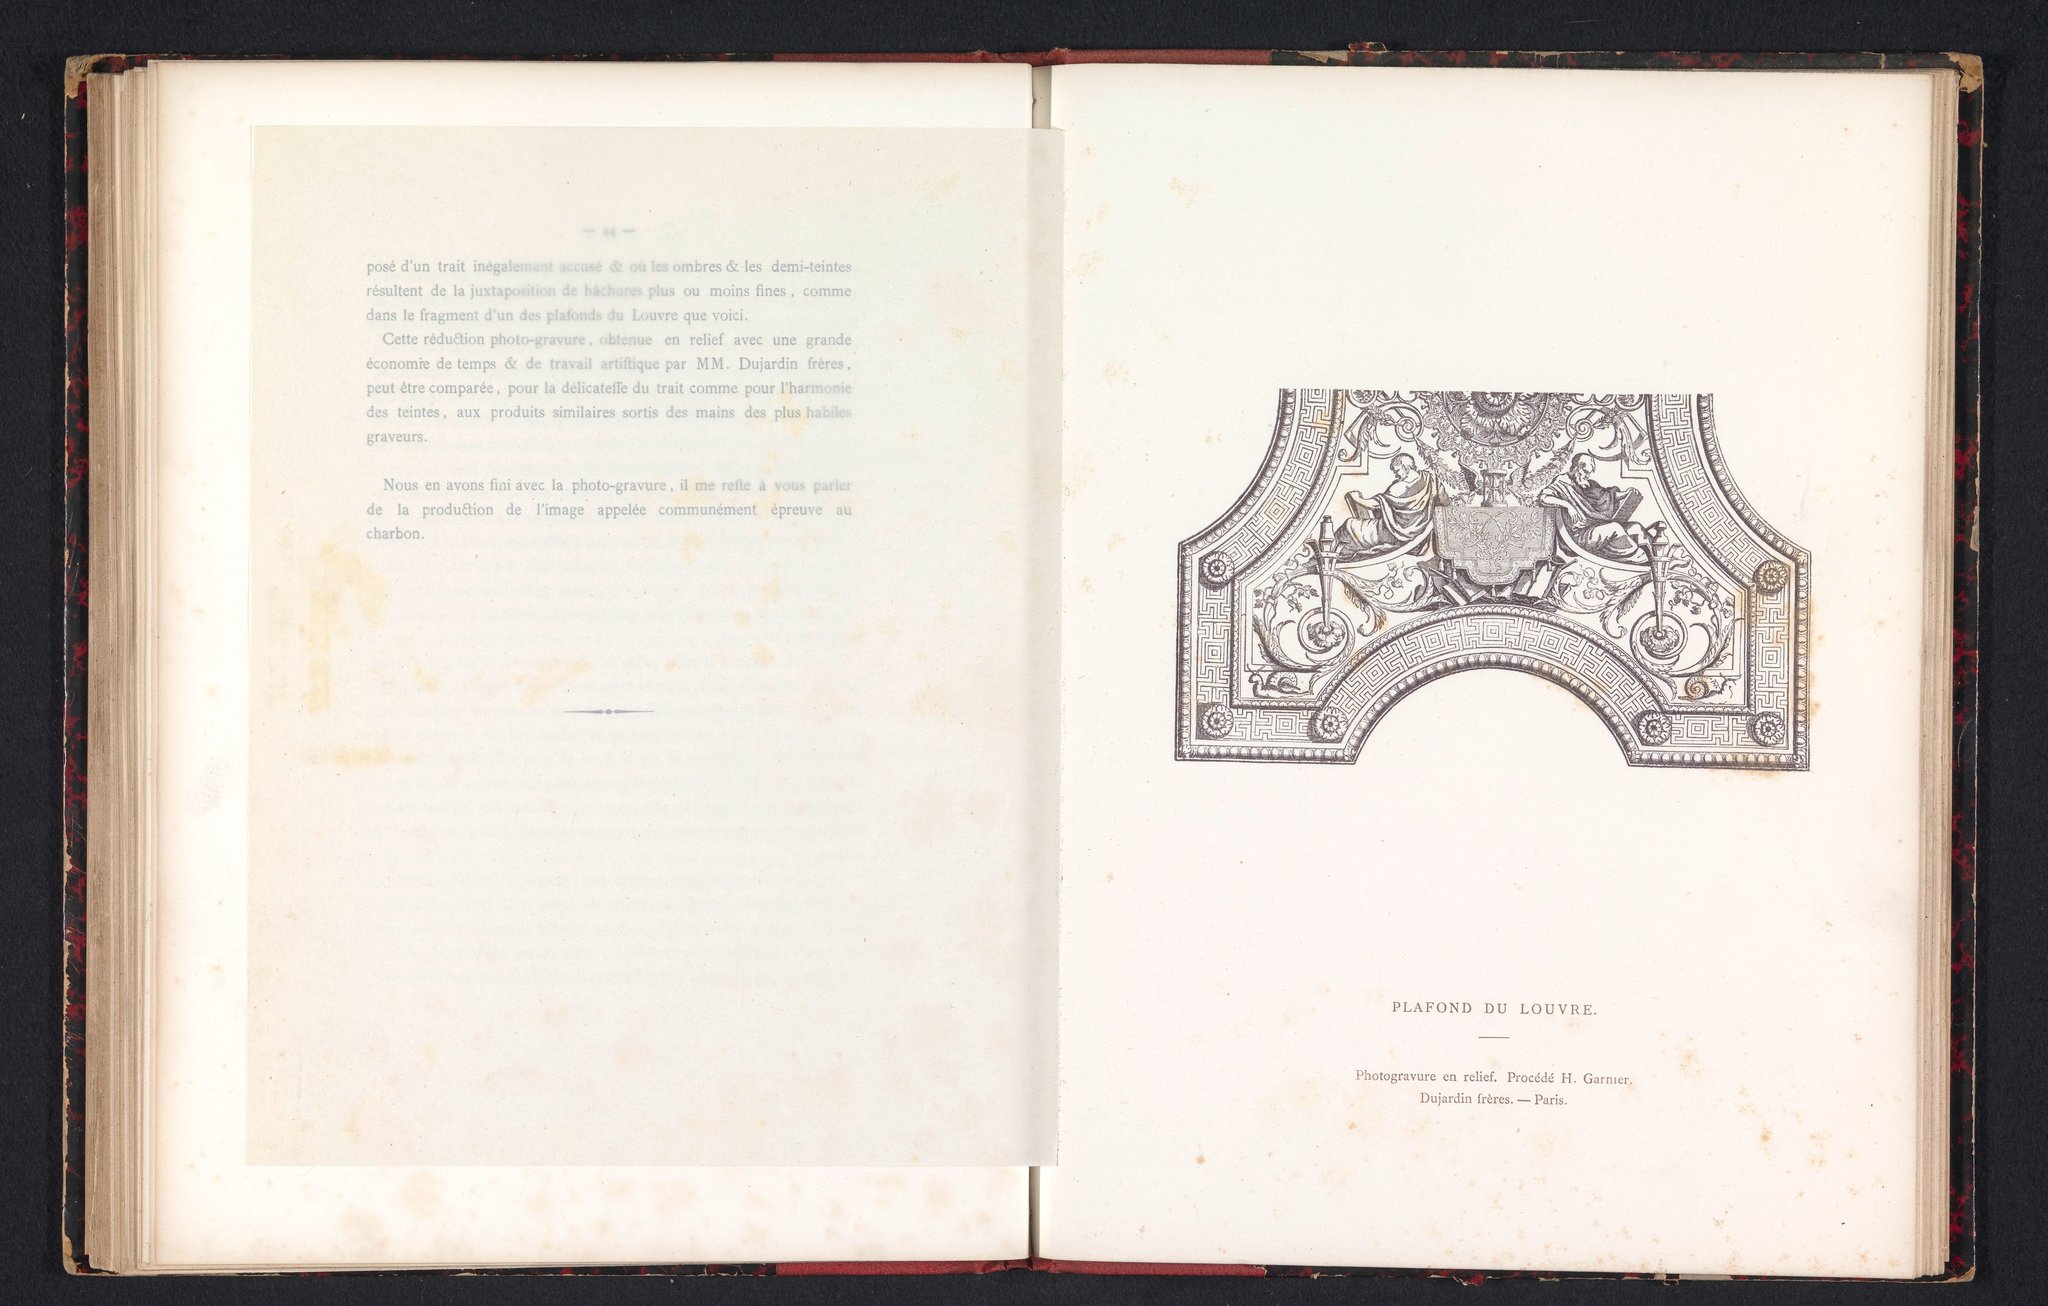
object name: reproduction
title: Plafond du Louvre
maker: Anonymous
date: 1859-1869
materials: paper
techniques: photoaquatint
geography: fontainebleau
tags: (decorated) ceiling